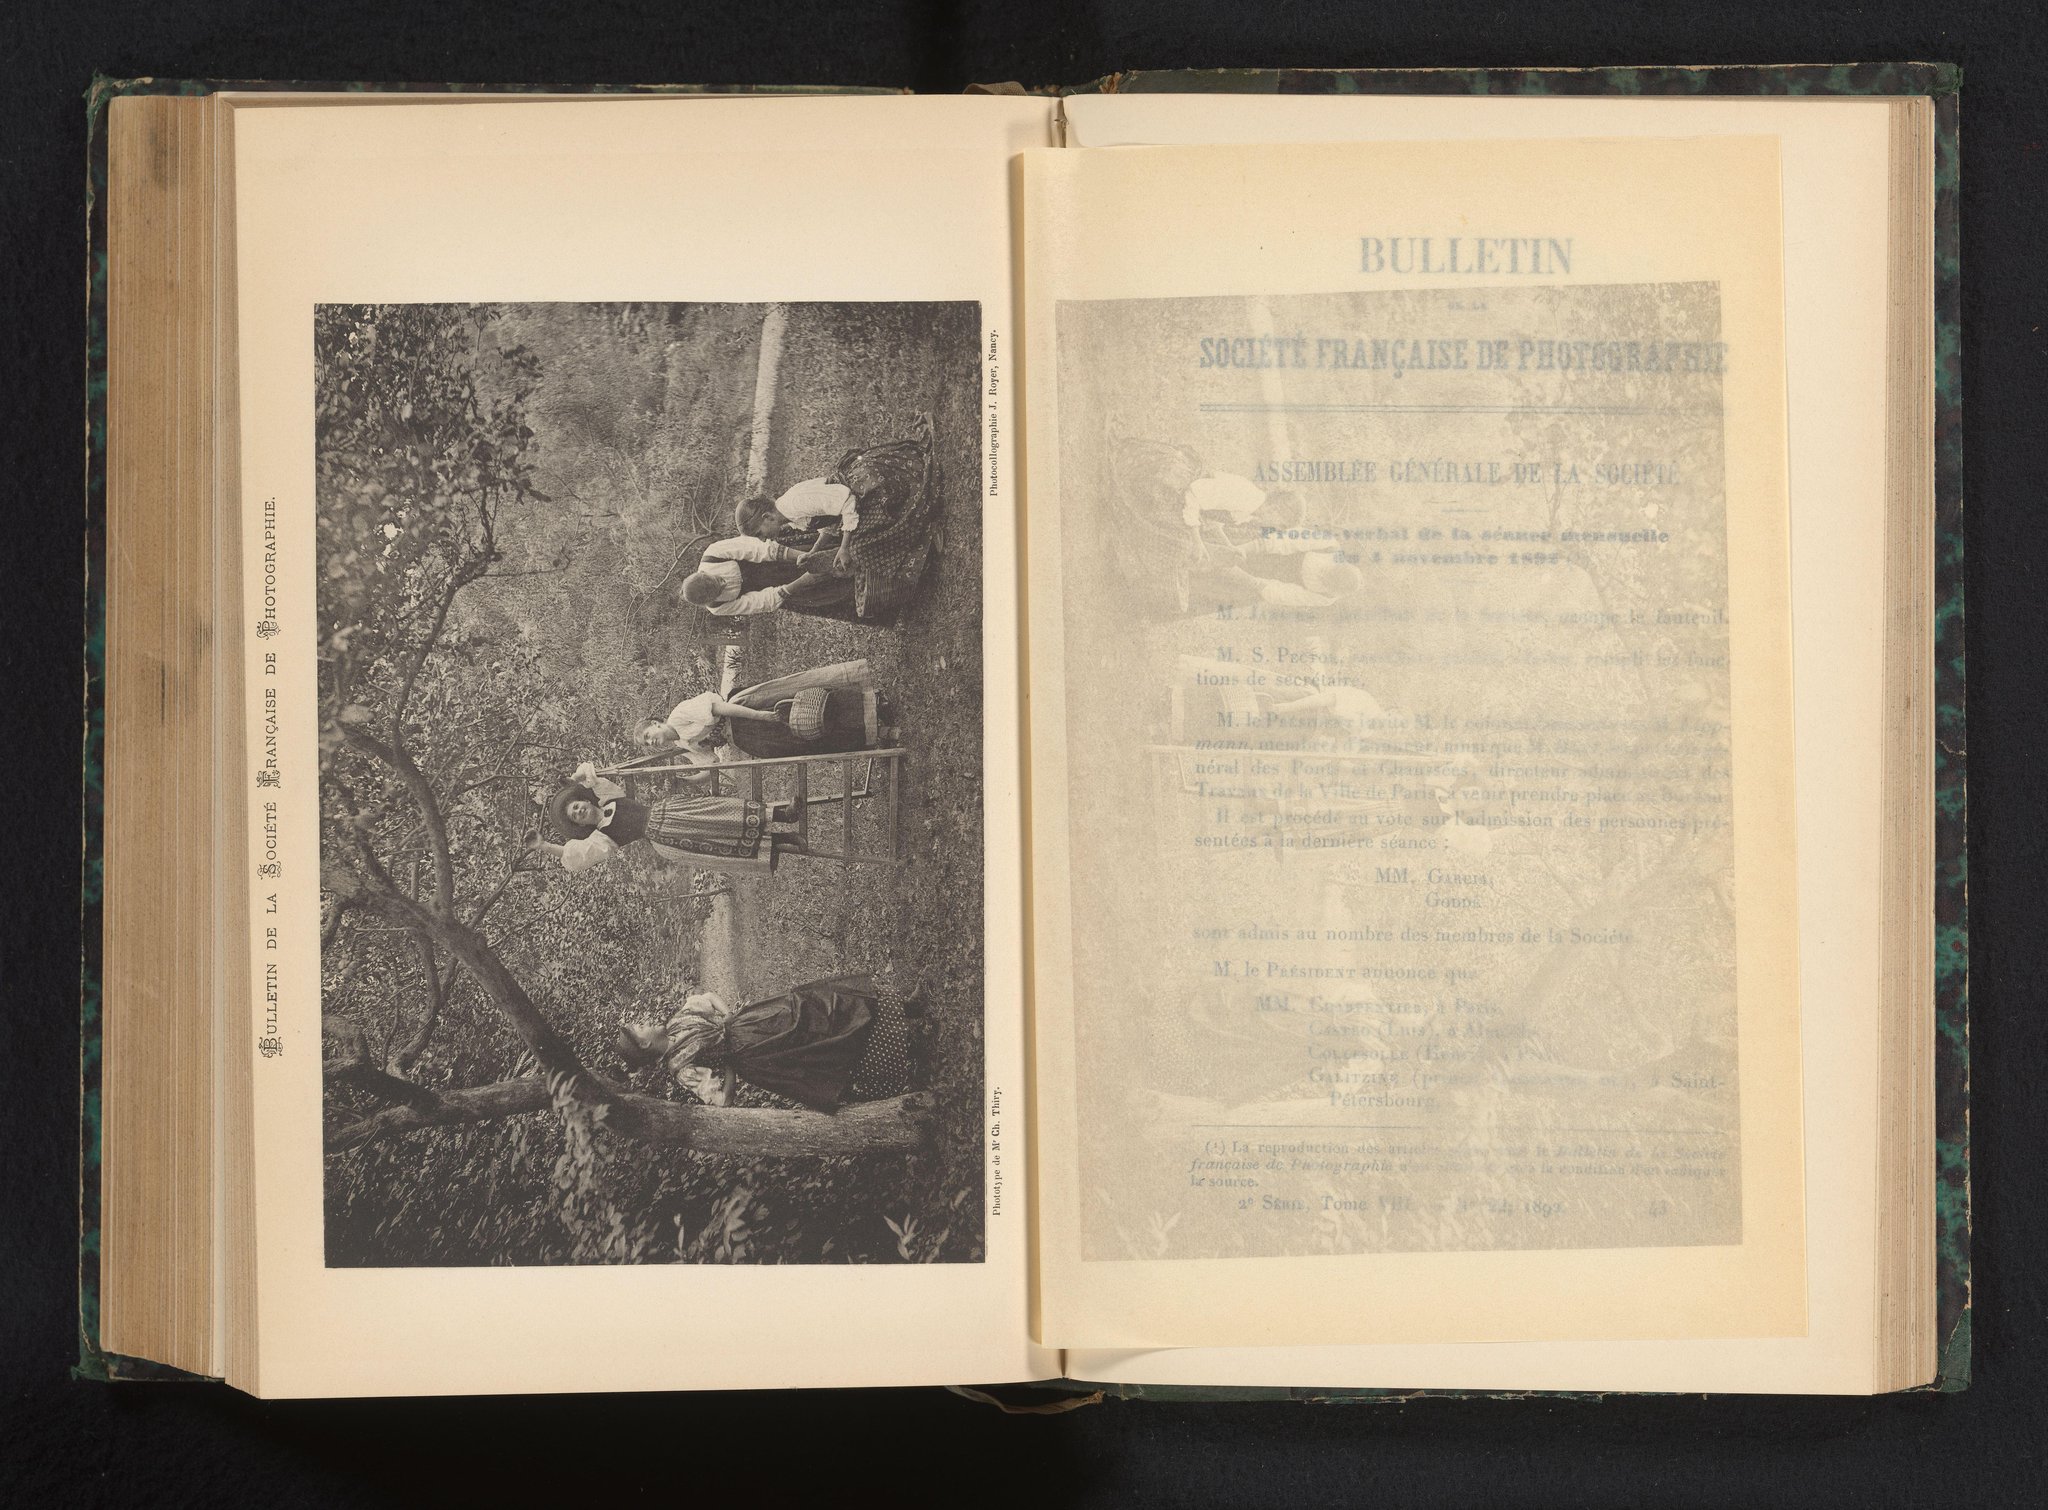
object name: photomechanical print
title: Fruitoogst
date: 1887-1892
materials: paper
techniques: photograph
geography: nancy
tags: fruit harvest, reaping, picking, mowing ~ harvest